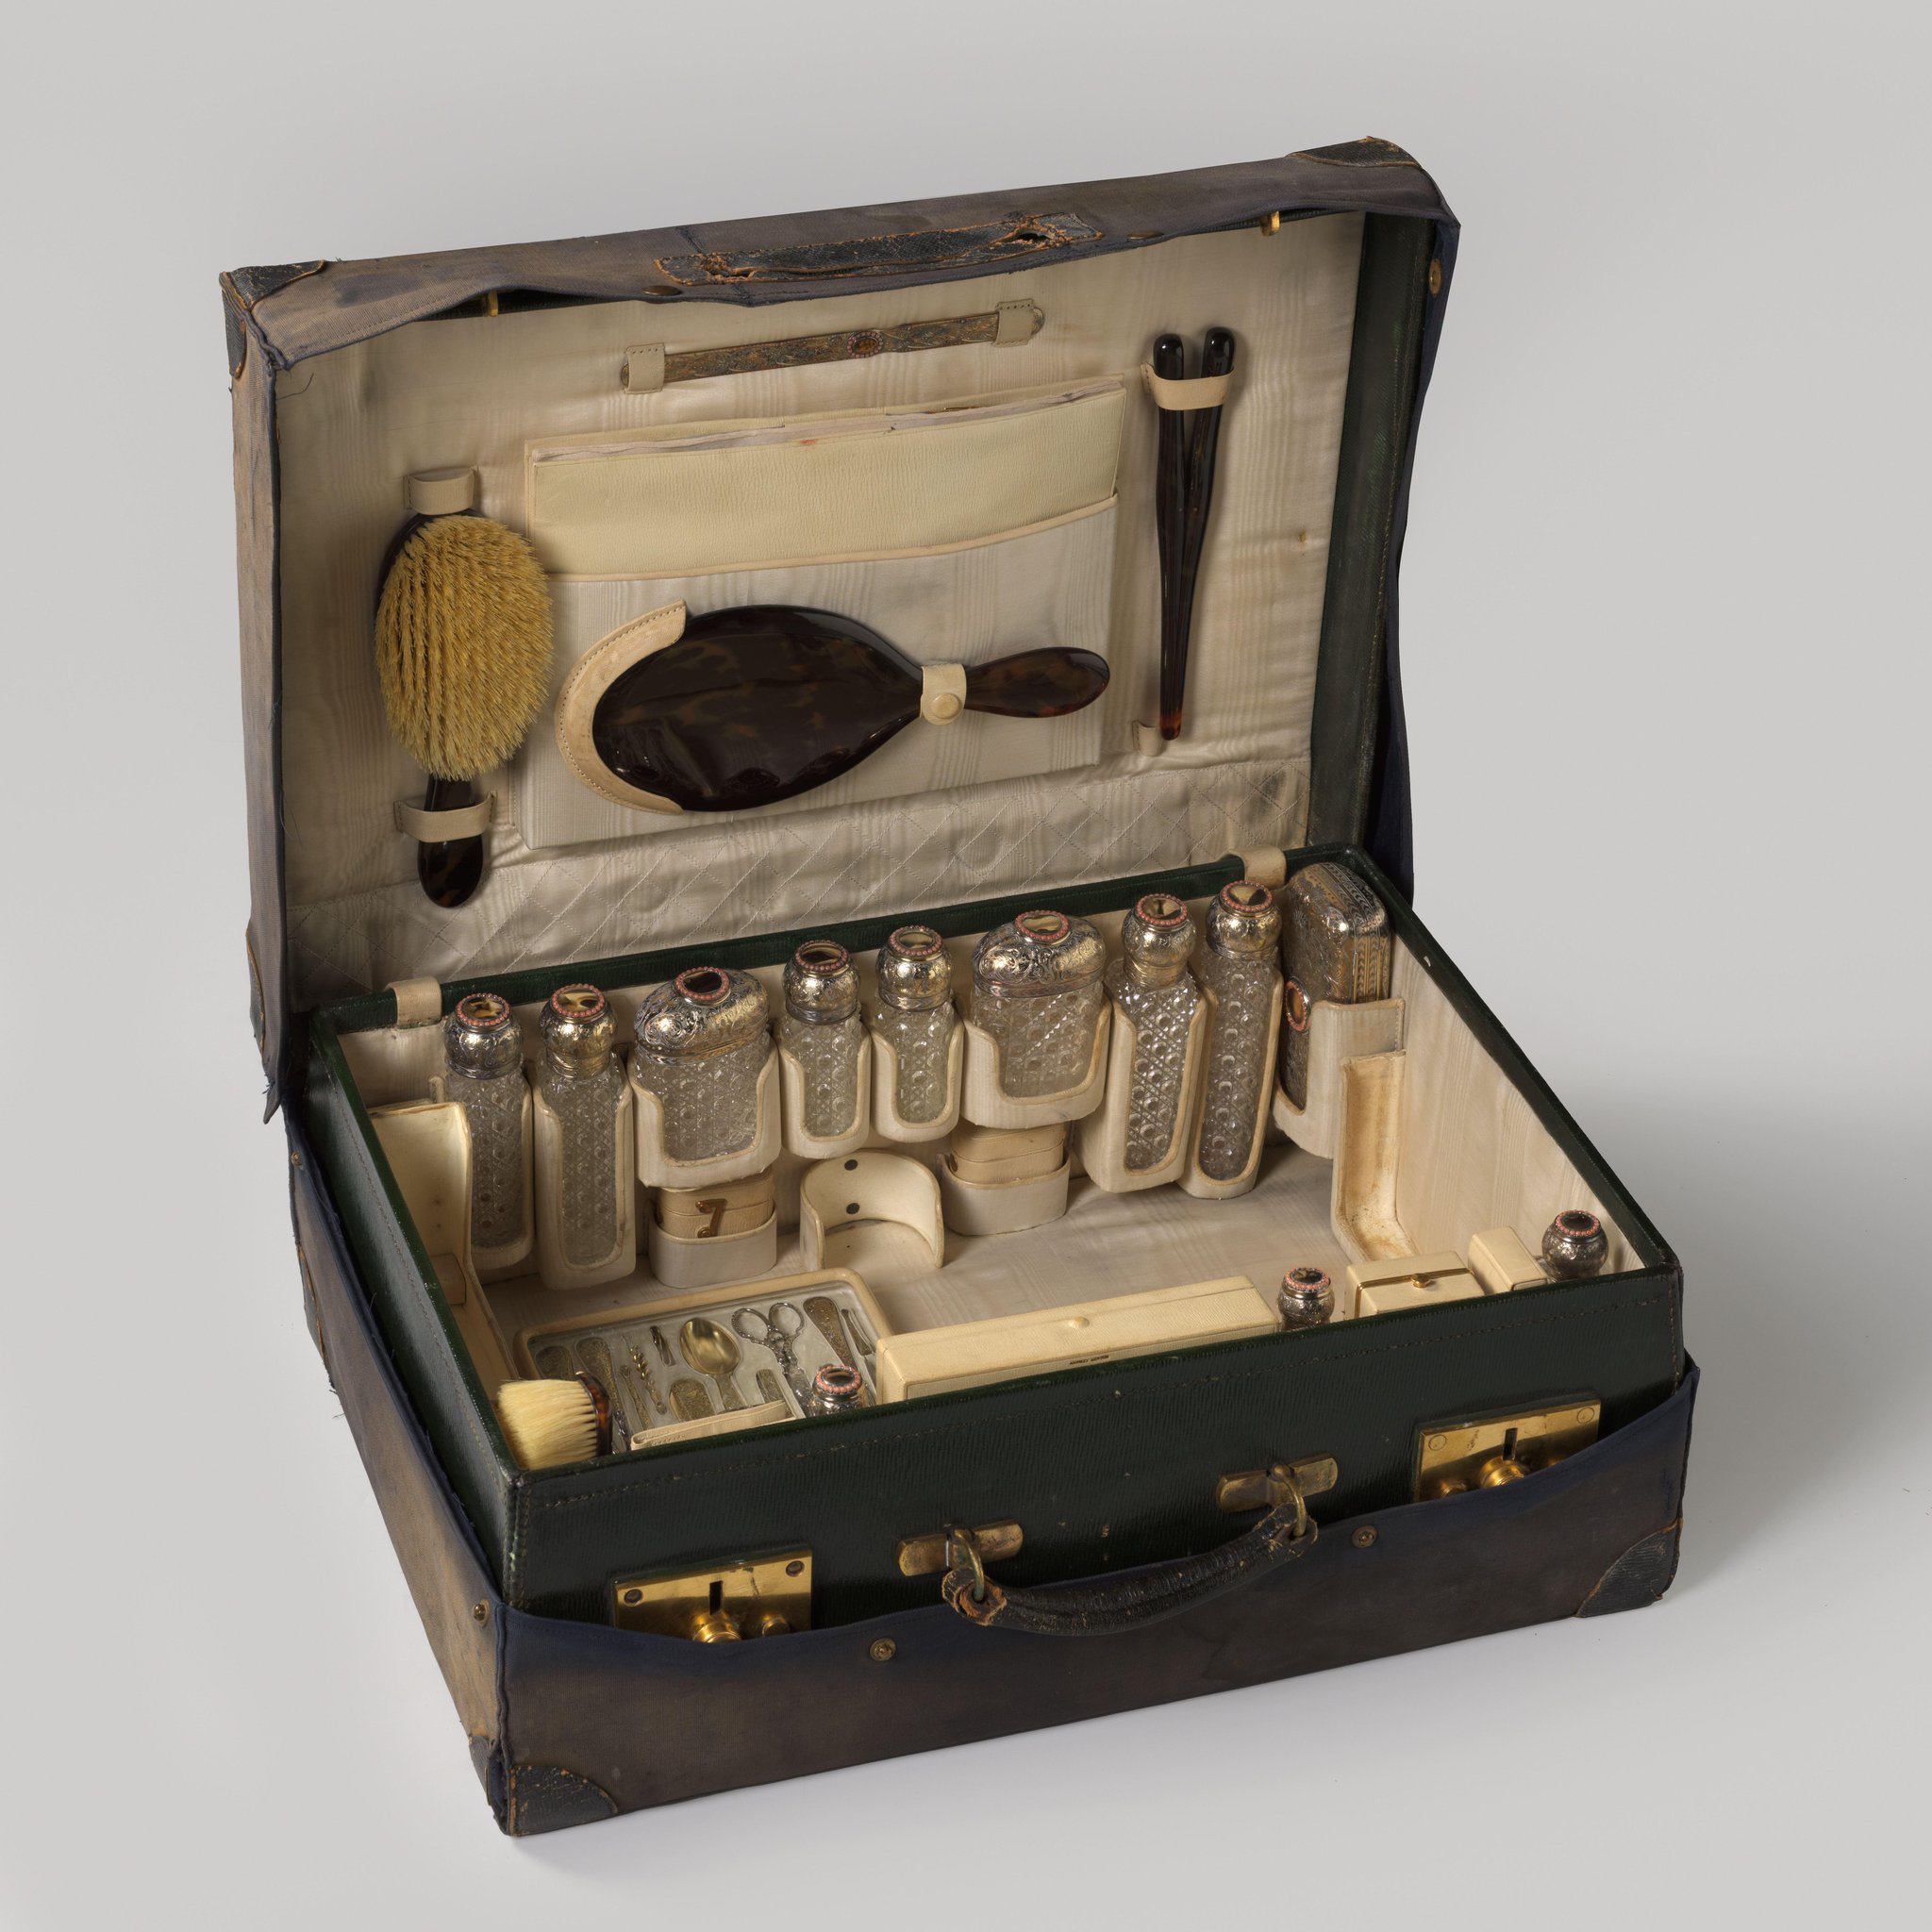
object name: reisnecessaire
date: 1883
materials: canvas, leather, silk, silver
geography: london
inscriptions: maker's mark: ‘JB’, maker's mark: ‘C.A’, maker's mark: ‘B&C, Sheffield, 1869’, maker's mark: ‘TJ, Londen, 1854’